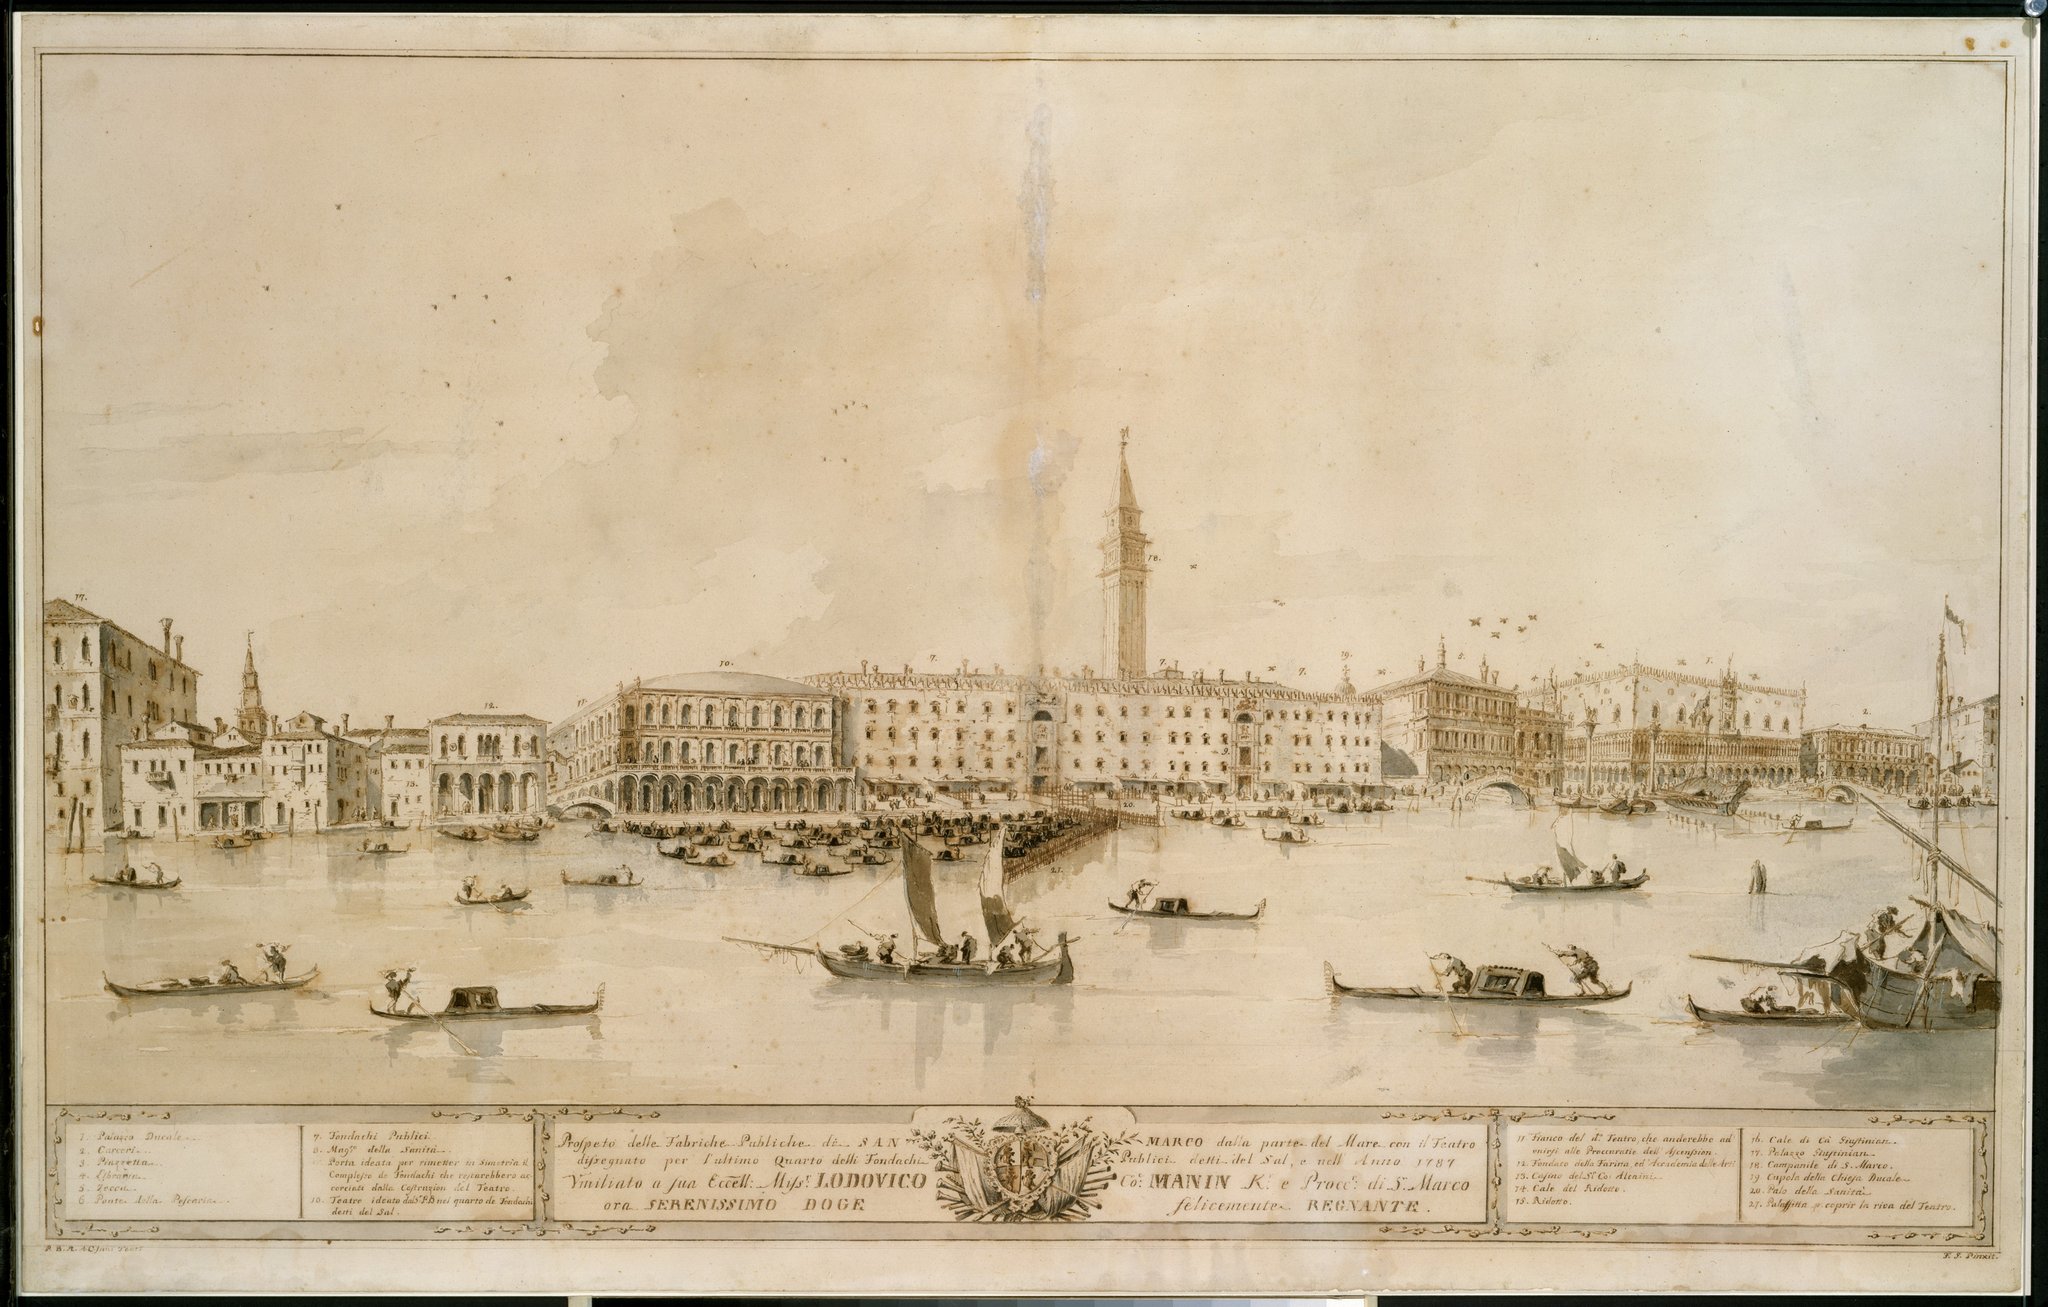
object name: drawing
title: Panorama of Venice from the Bacino di San Marco, Including the Project for the Proposed Teatro Manin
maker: francesco guardi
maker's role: artist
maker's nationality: italian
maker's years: 1712-1793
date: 1788-1793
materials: ink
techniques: pen, wash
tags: buildings,canals,boats,venice